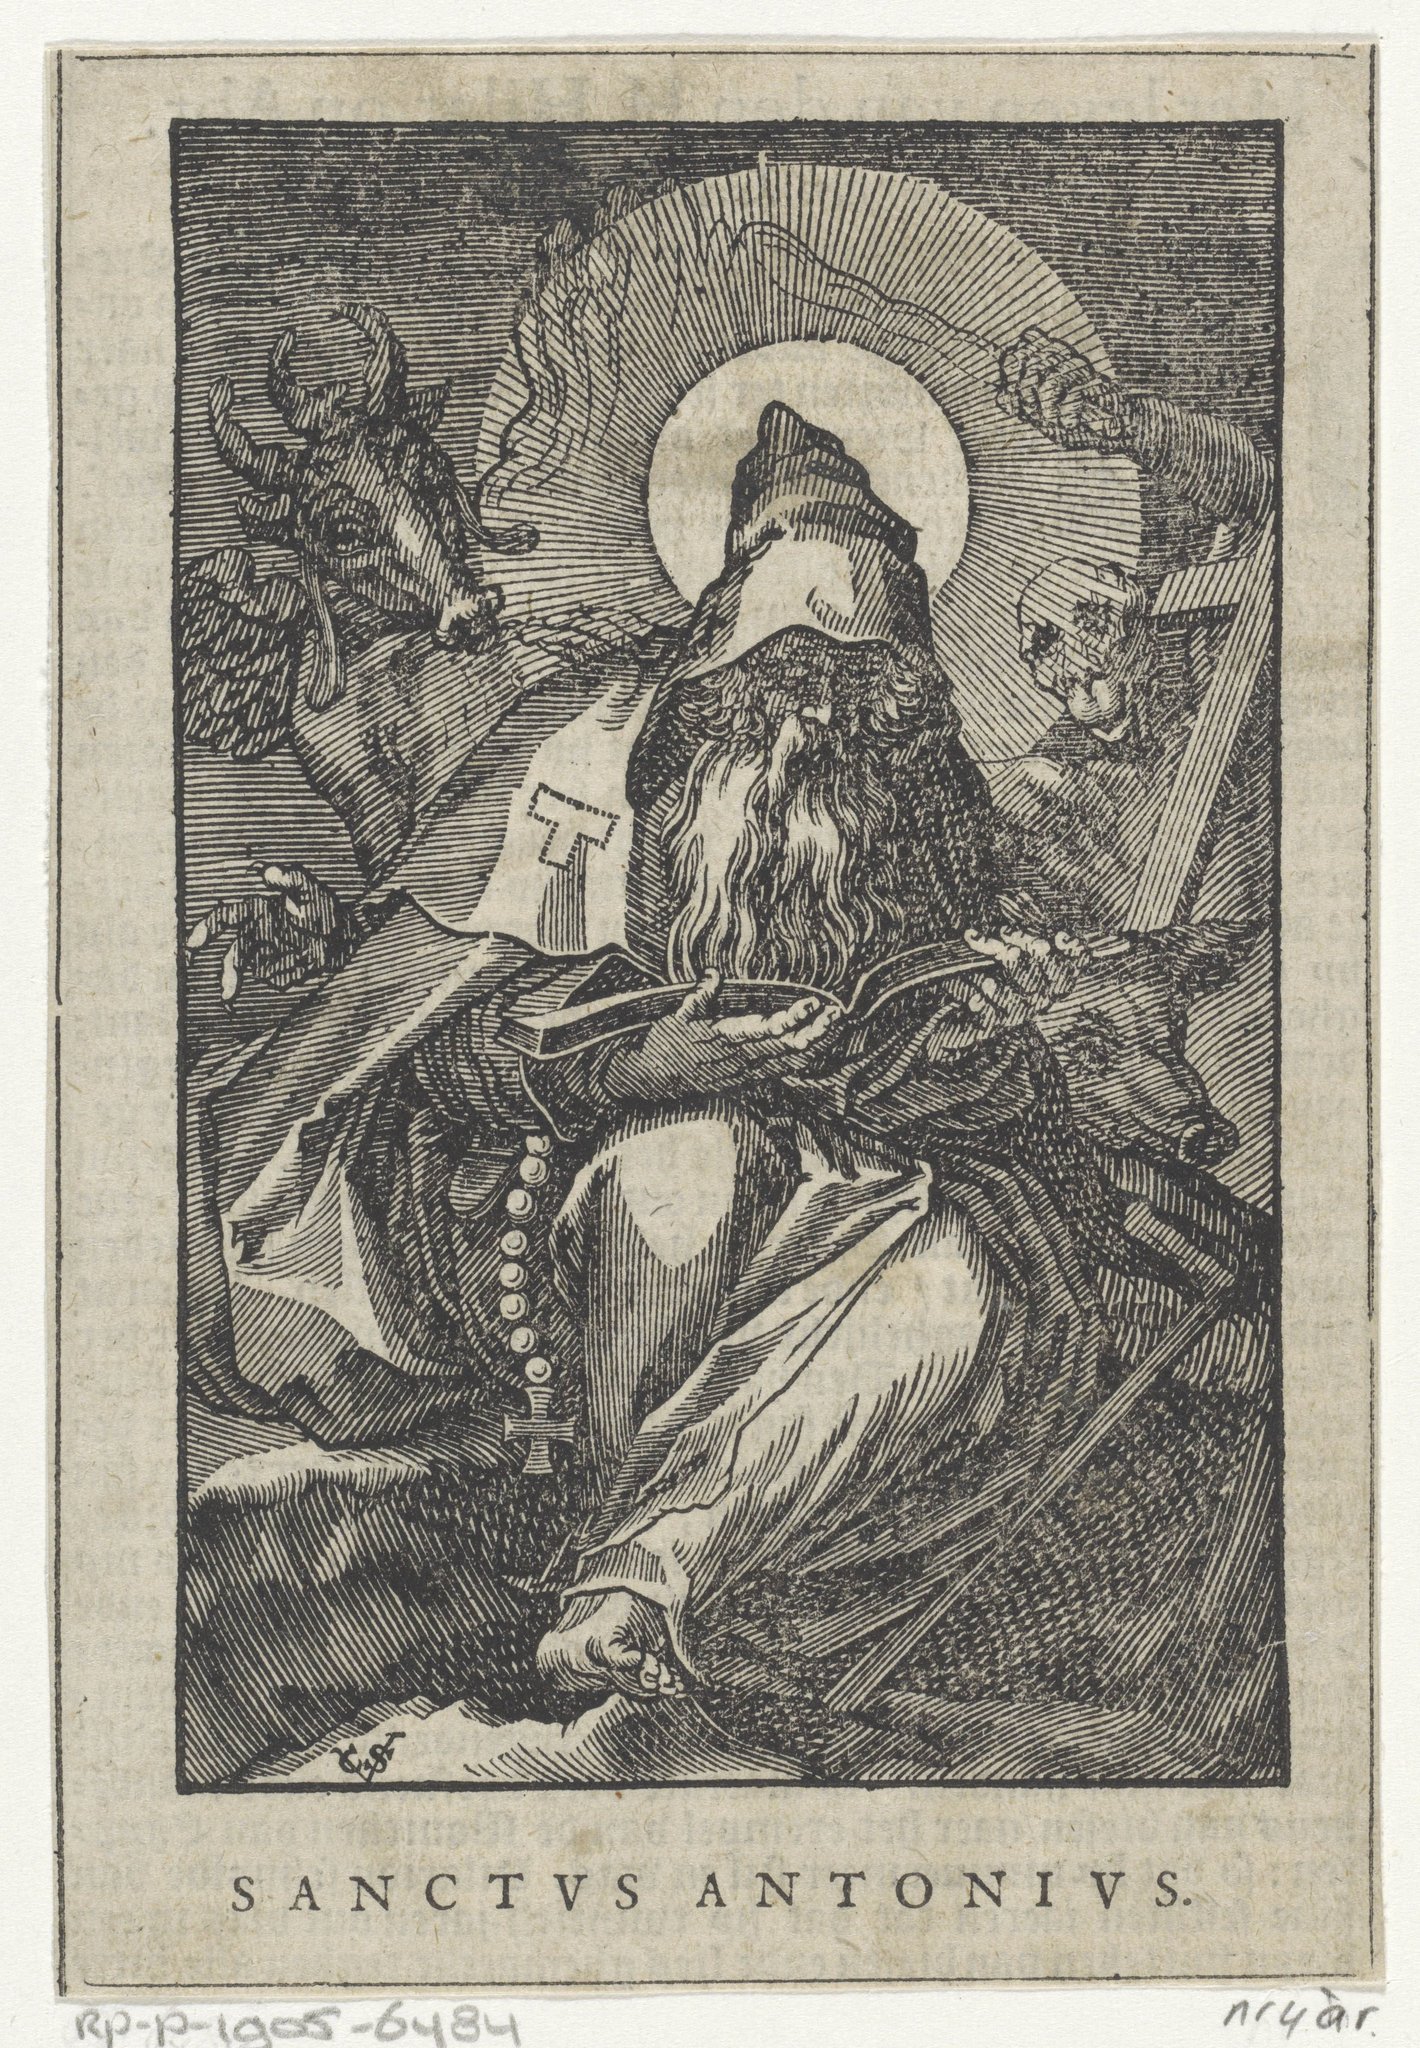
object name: book illustration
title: Heilige Antonius de Grote van Egypte als kluizenaar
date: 1644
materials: paper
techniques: letterpress printing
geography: amsterdam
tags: anchorite, hermit, the hermit antony abbot (antonius abbas) of egypt, also called the great; possible attributes: bell, book, t-shaped staff, flames, pig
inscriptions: collector's mark: Lugt 2228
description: Prent uit: Rosweyde, Heribert. 'tBosch der eremyten ende eremitinnen, van Aegypten ende Palestinen. Amsterdam: Pieter Jacobsz. Paets, 1644.